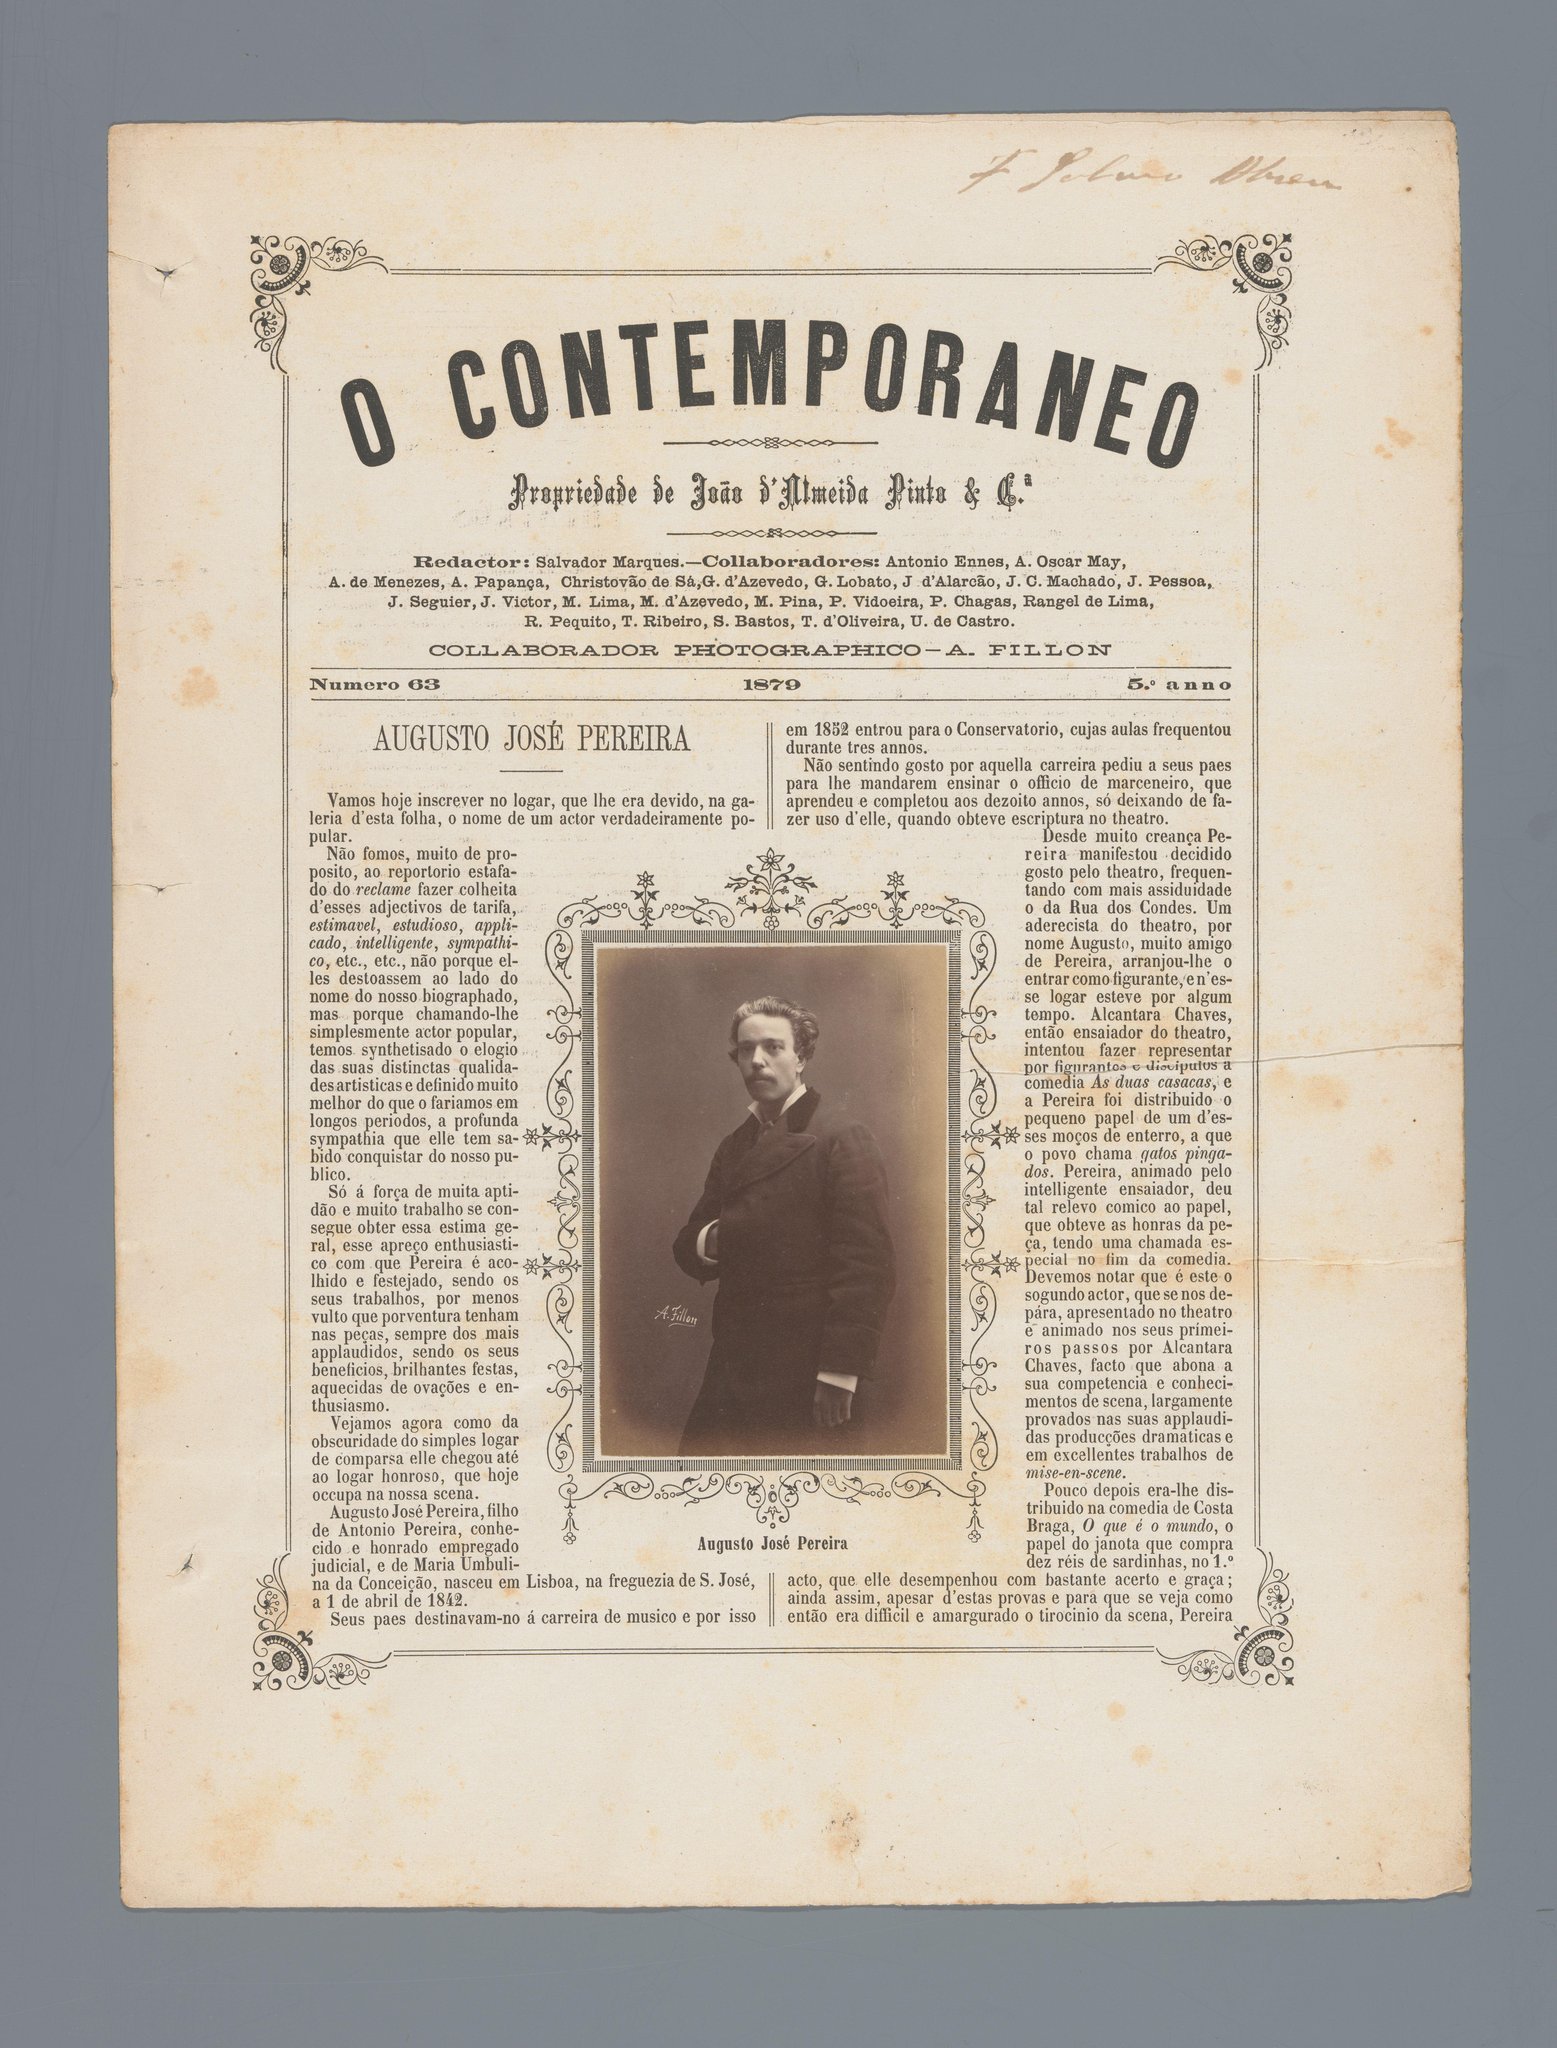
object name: magazine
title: O contemporaneo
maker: alfred fillon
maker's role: fotograaf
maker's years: 1825-1881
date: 1874-1879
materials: paper, photographic support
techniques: albumen print, printing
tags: historical persons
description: Op de voorpagina bevindt zich een portret van Augusto José Pereira.